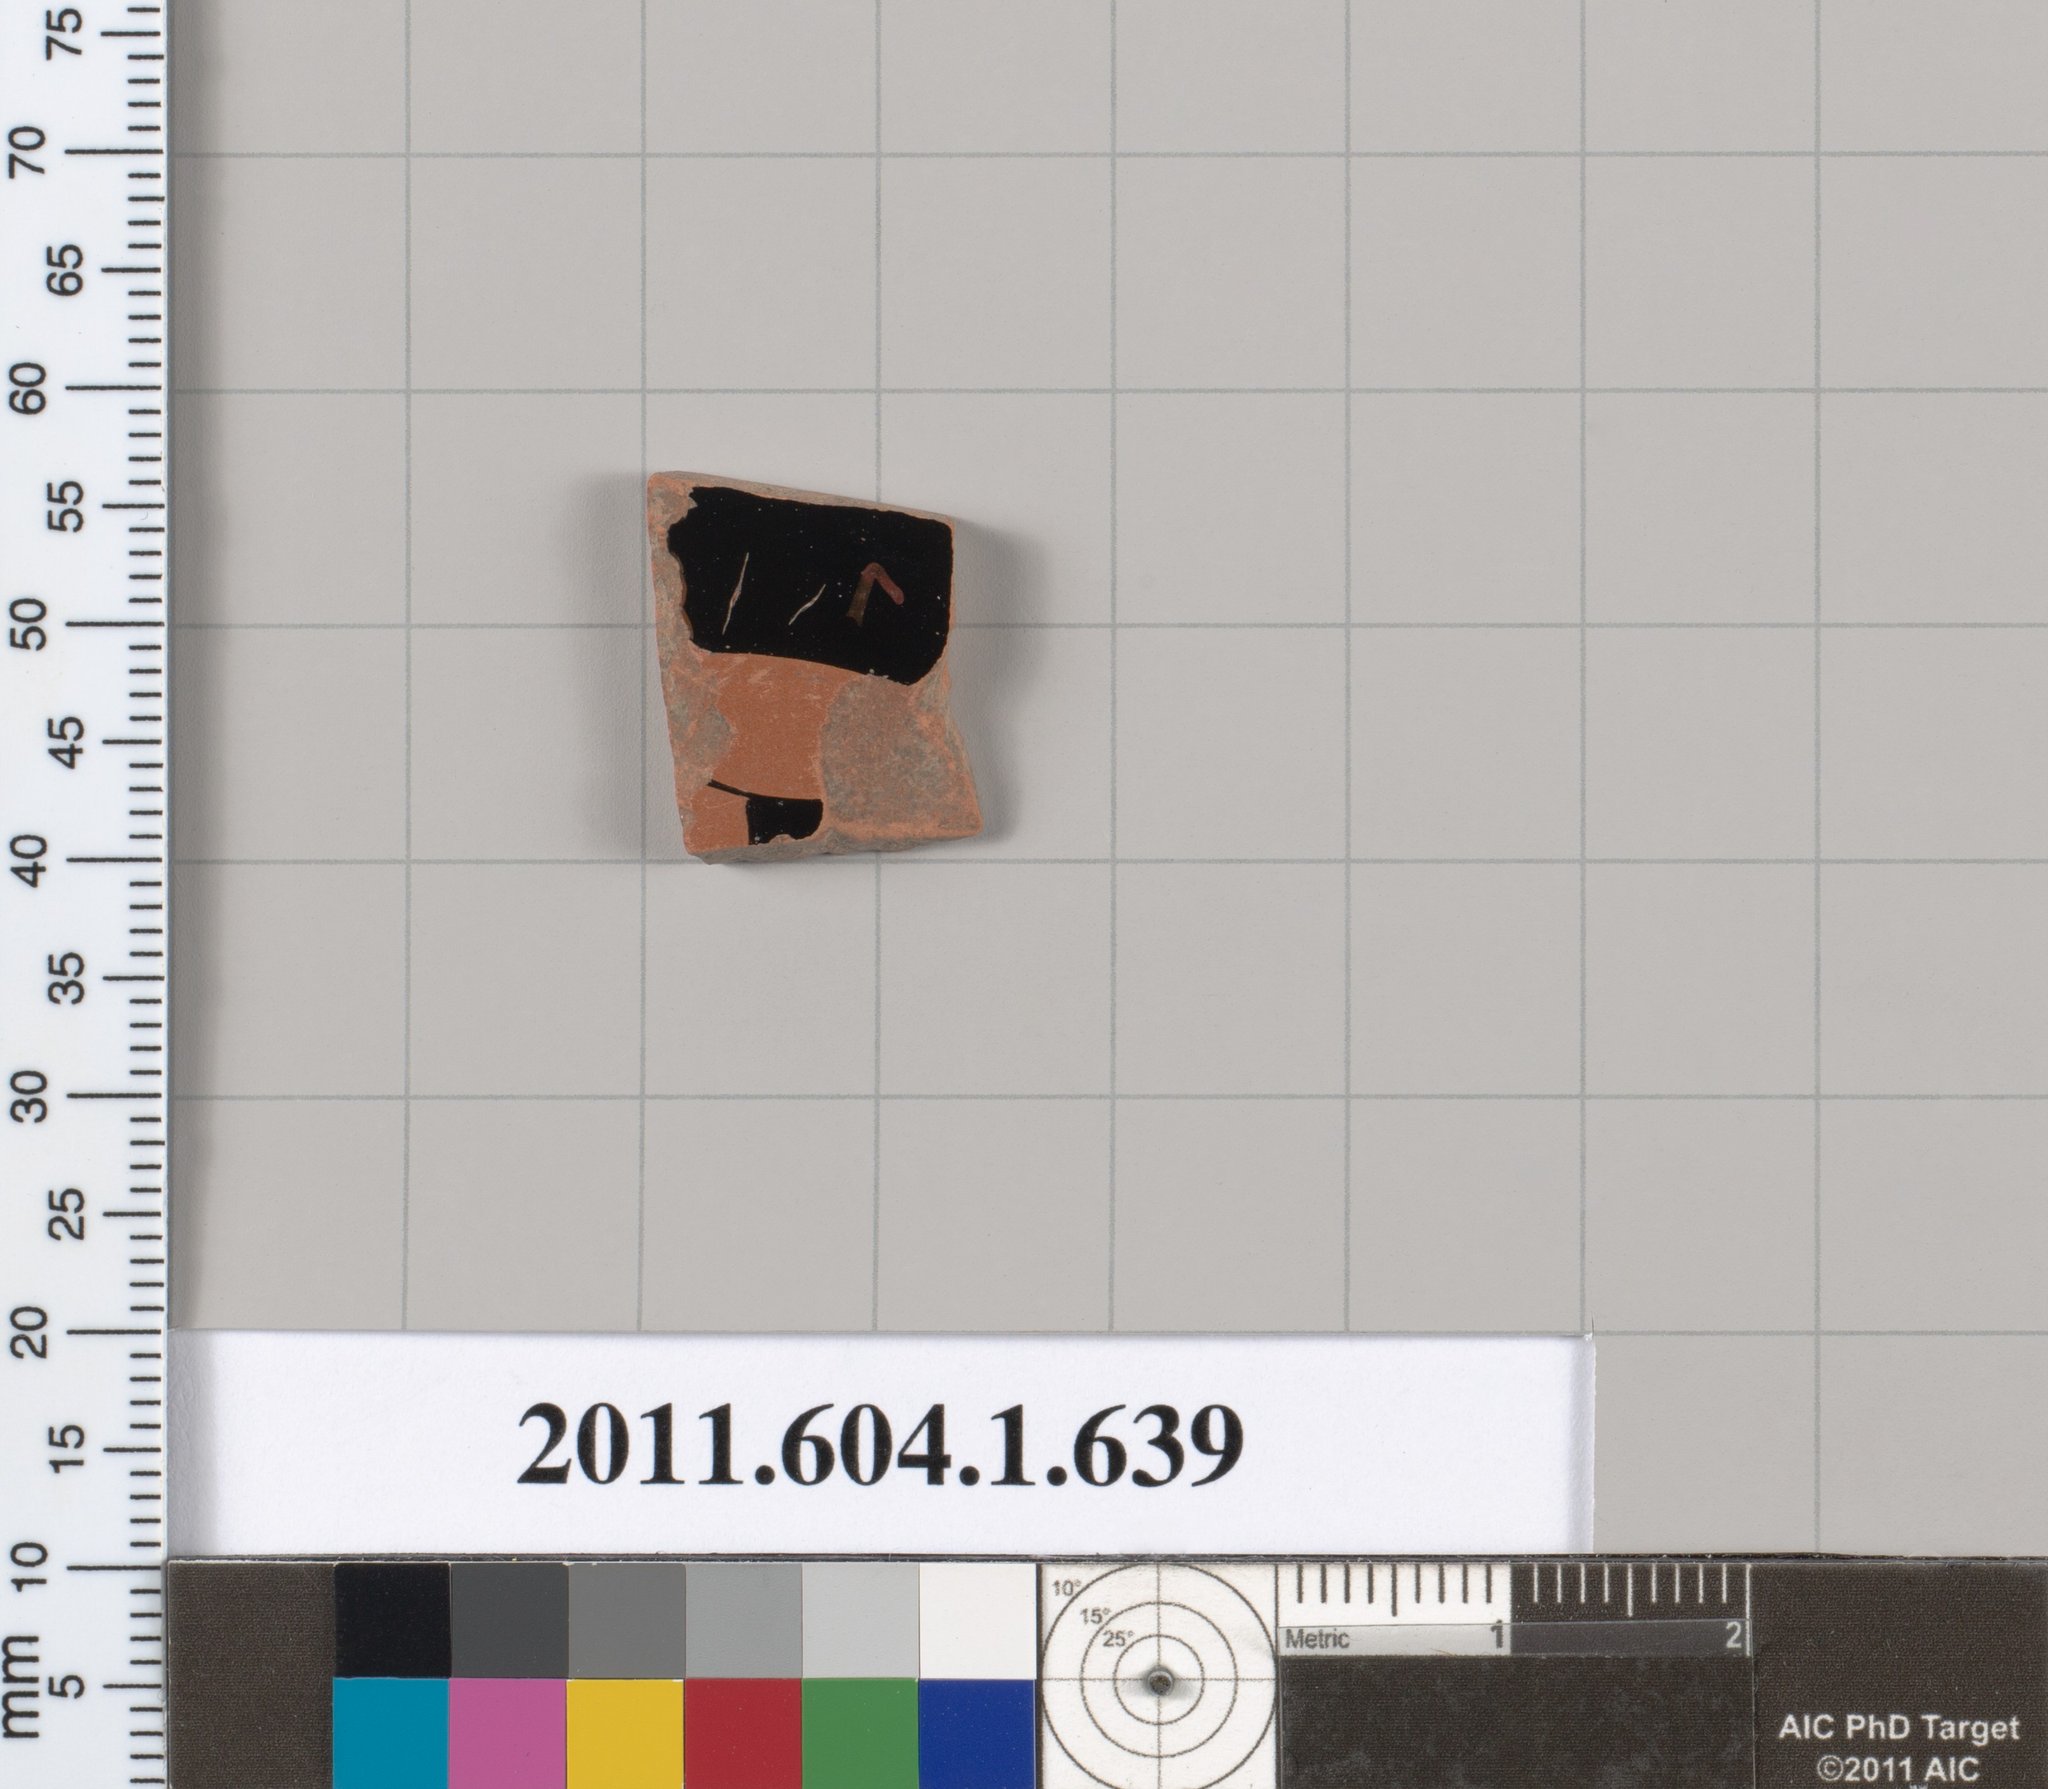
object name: kylix fragment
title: Terracotta fragment of a kylix (drinking cup)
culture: greek, attic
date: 475-451 BCE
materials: terracotta